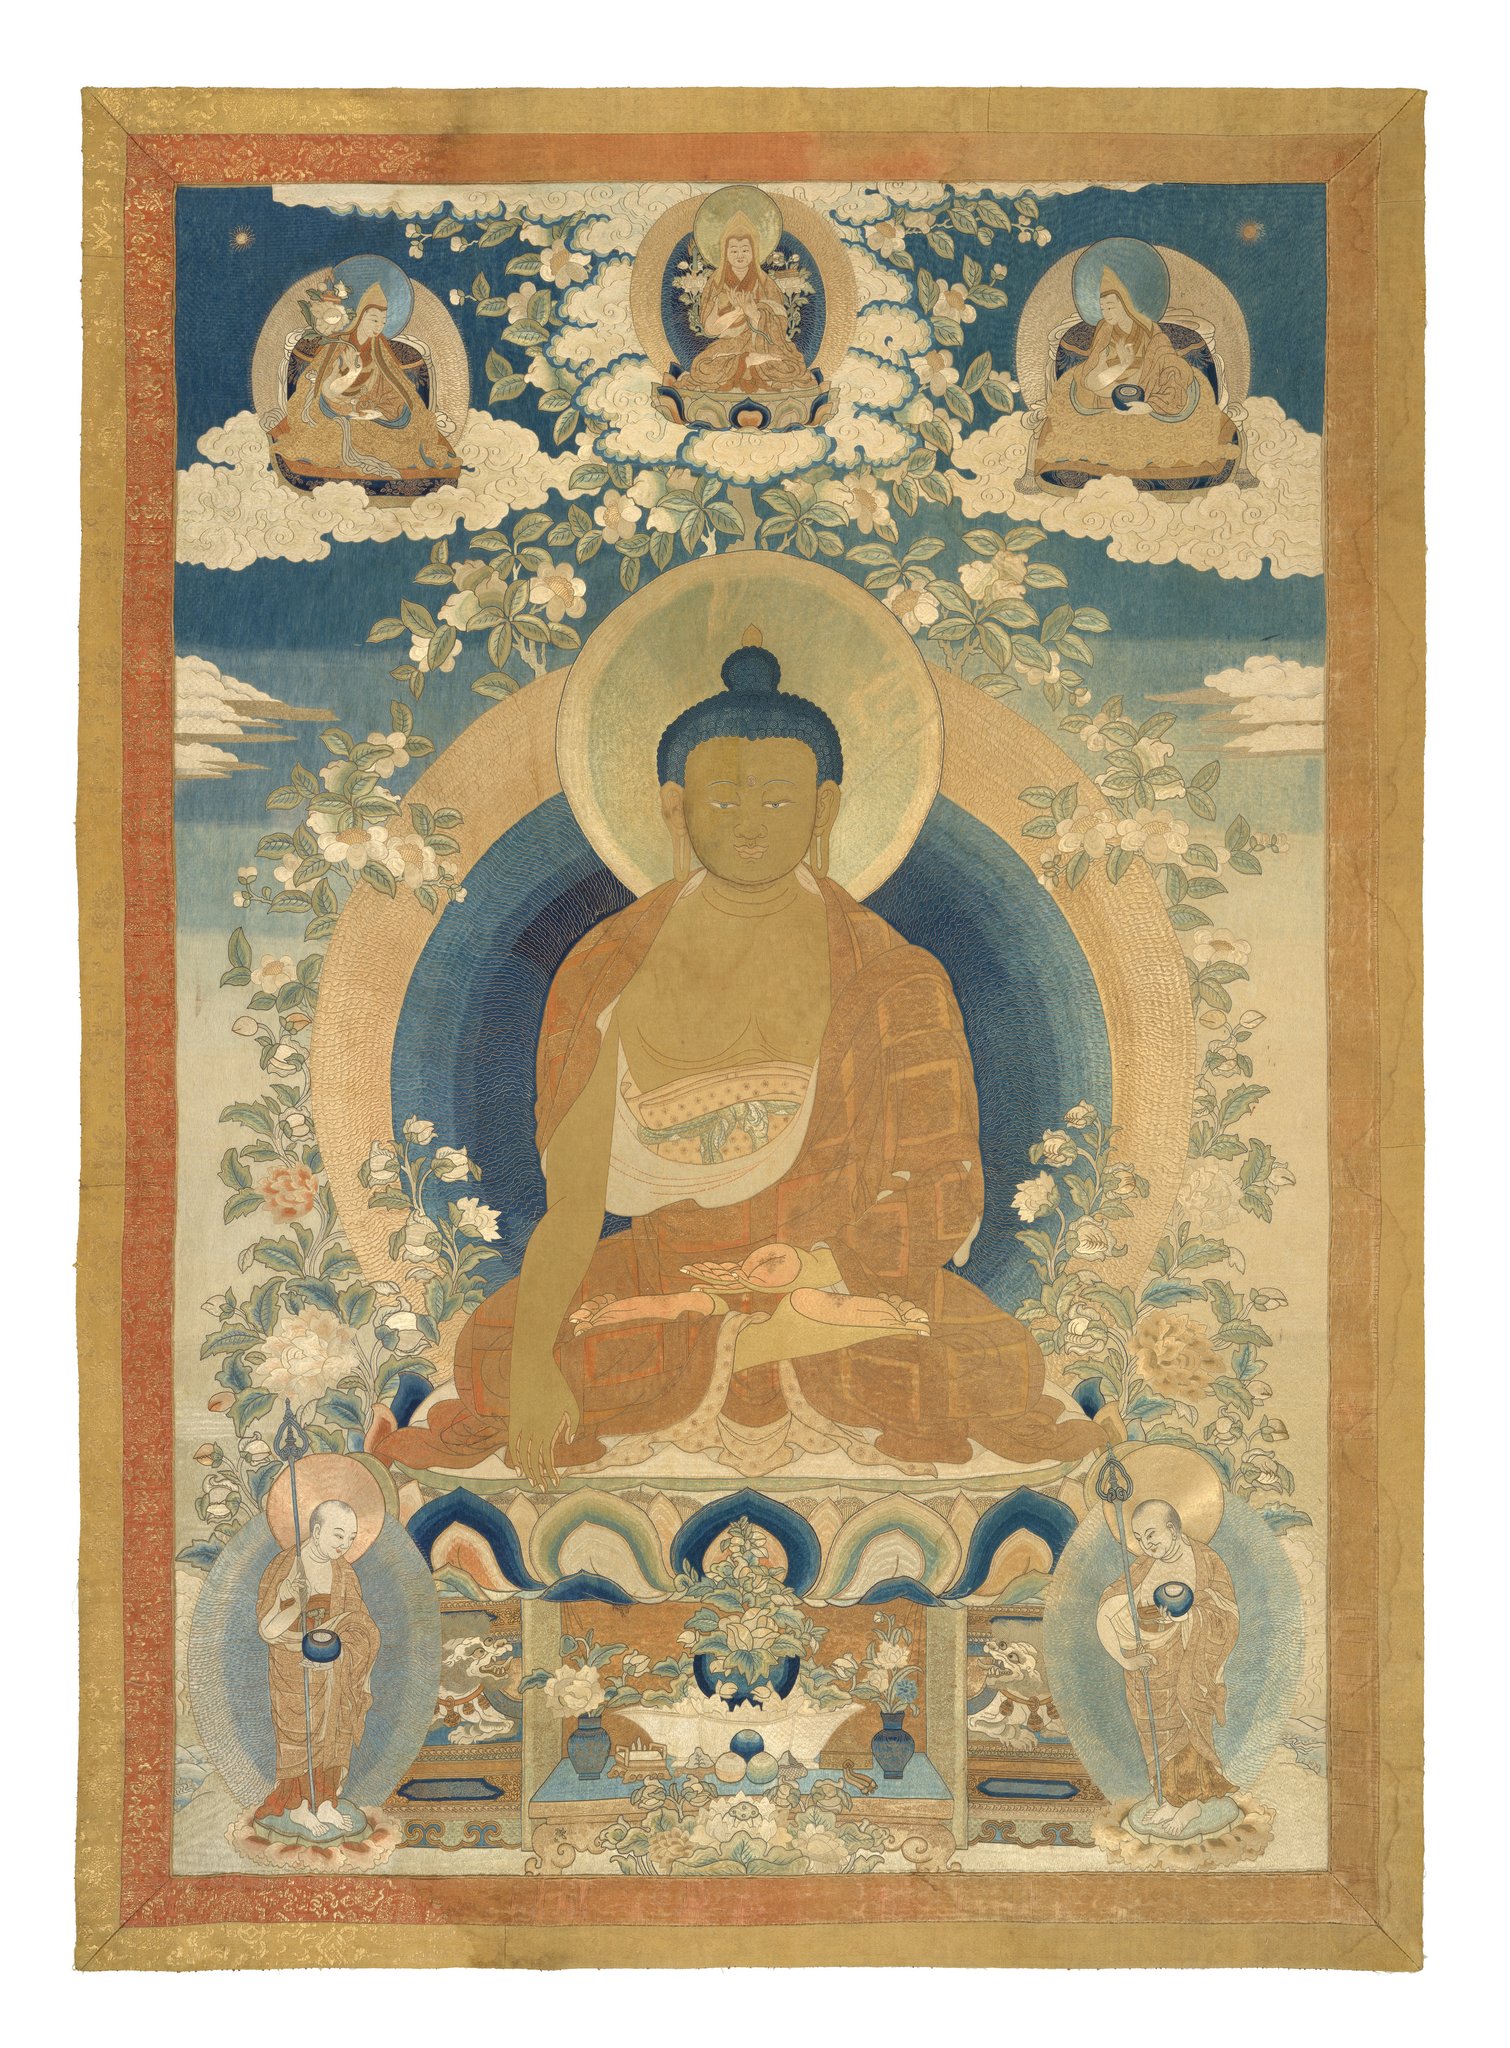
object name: thangka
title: Buddha Shakyamuni with disciples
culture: chinese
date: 1701-1733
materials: metal thread, silk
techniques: embroidery, weave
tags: flowers,leaves,buddha